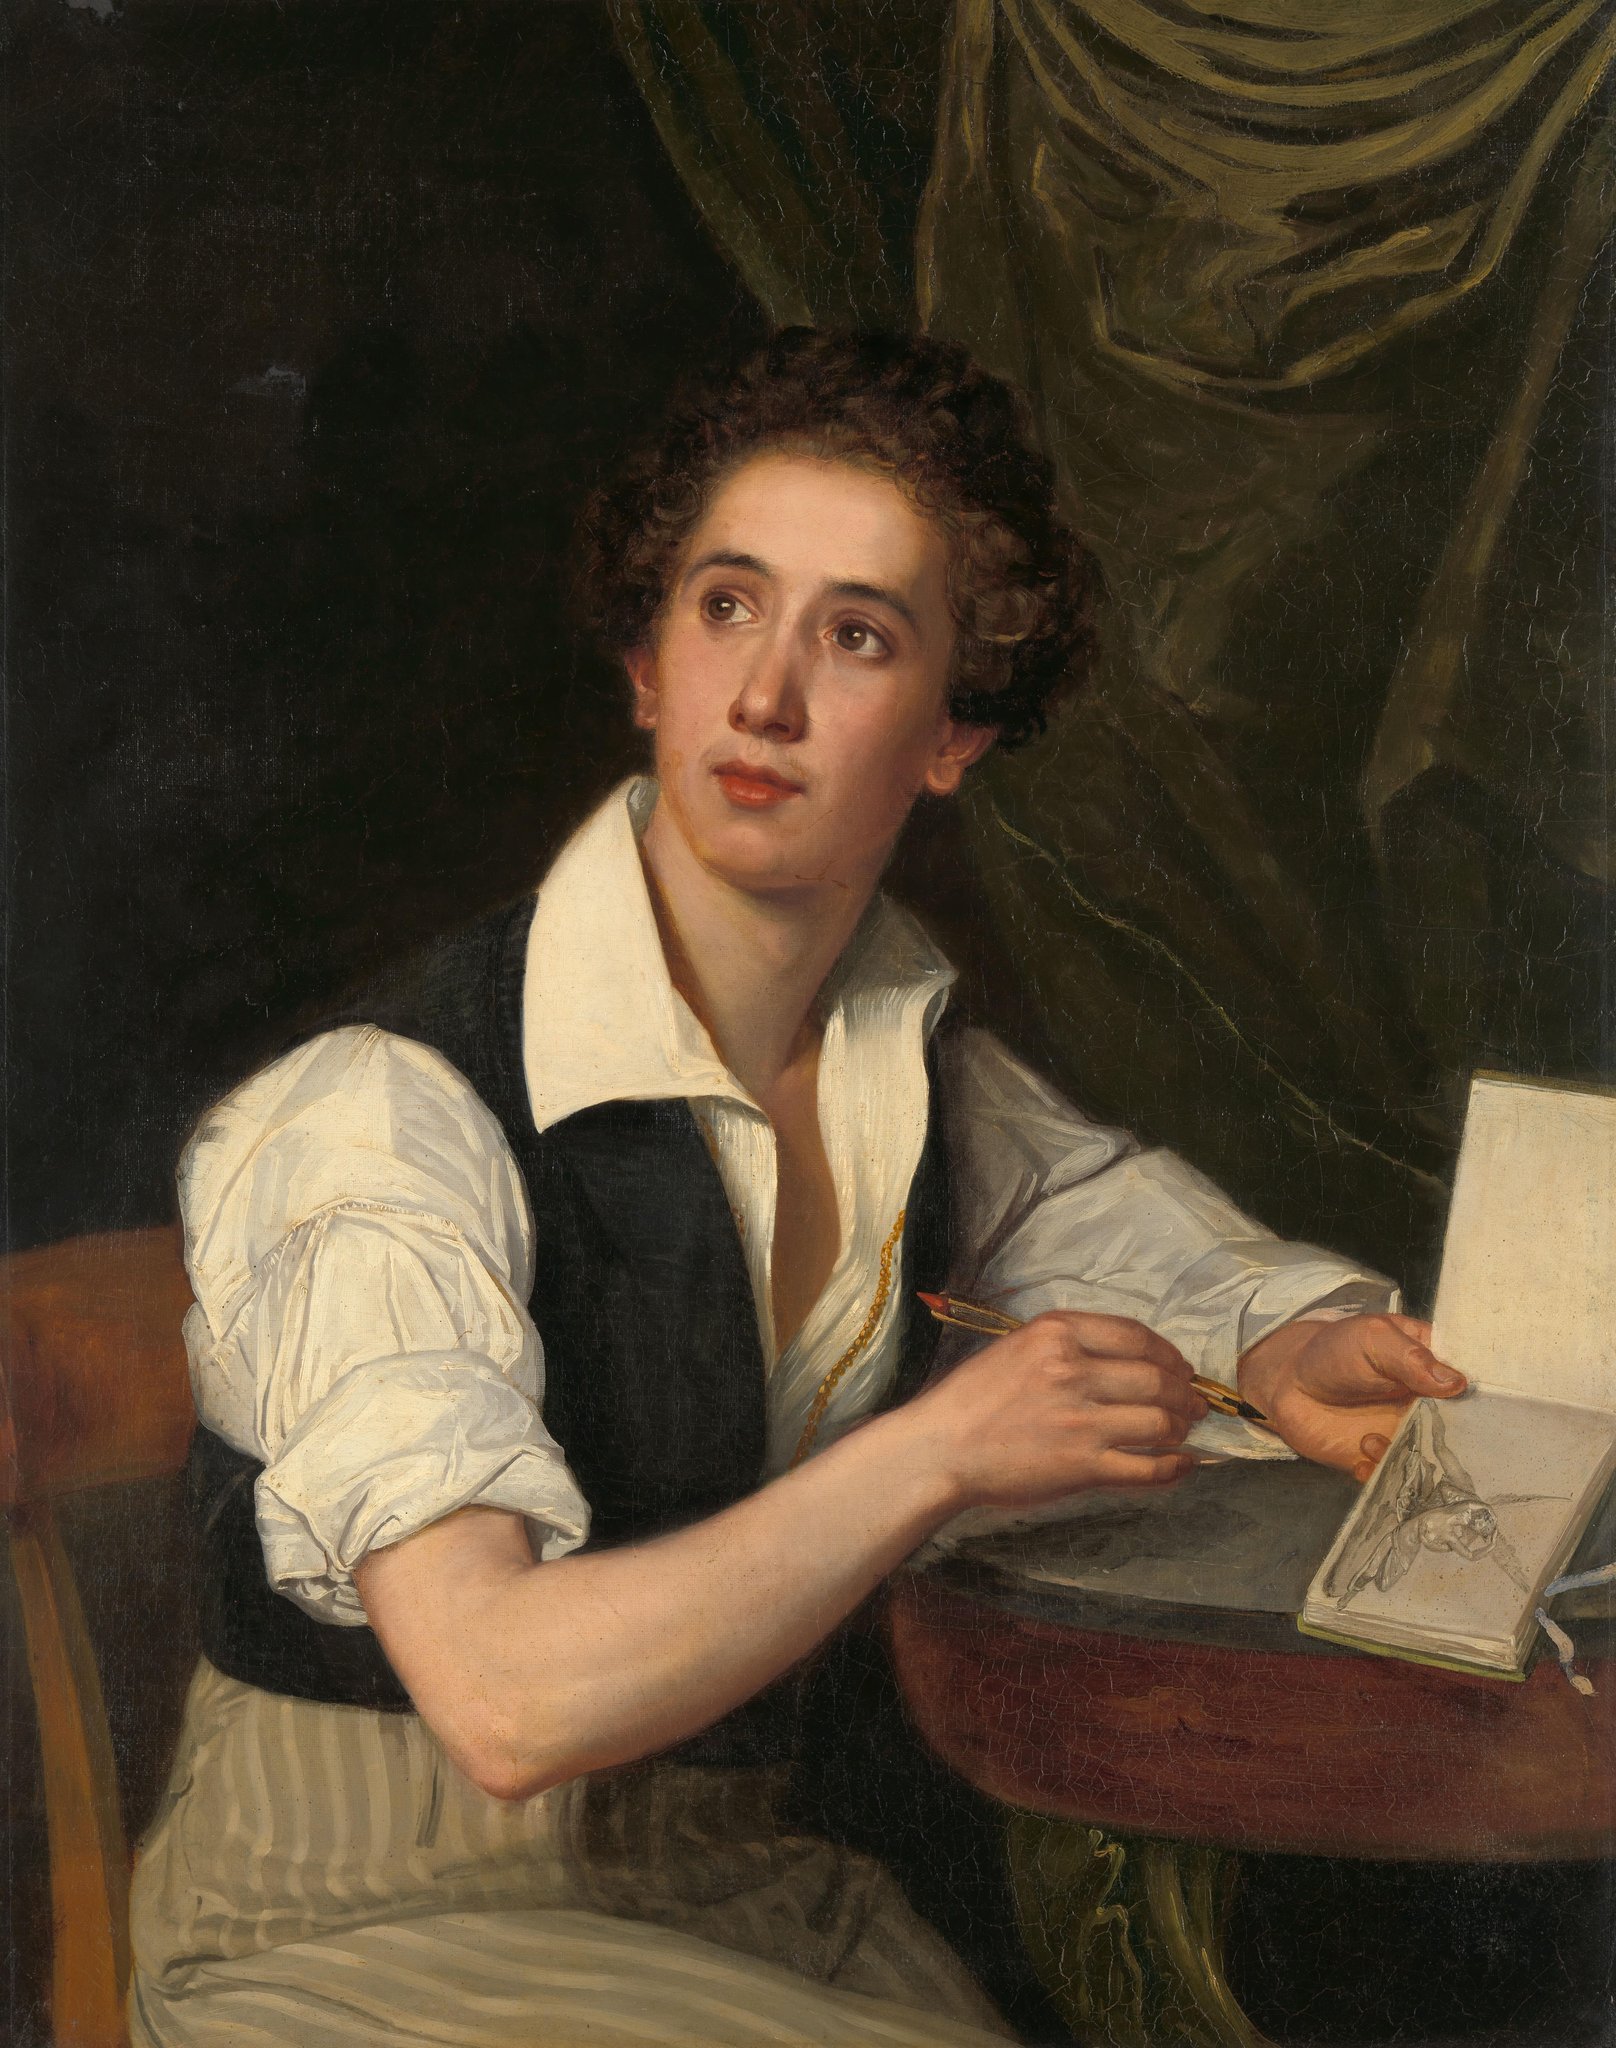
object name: painting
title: Self-Portrait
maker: charles saligo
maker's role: painter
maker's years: 1804-1874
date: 1824-1826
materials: canvas, oil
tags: painter, charles saligo, historical persons, portrait, self-portrait of painter, artist (in general) making preliminary designs, sketching, portrait, self-portrait of artist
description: Zelfportret van de schilder Charles Saligo op jonge leeftijd. Kniestuk, zittend aan een tafeltje met een schetsboek en een tekenpen in de hand.